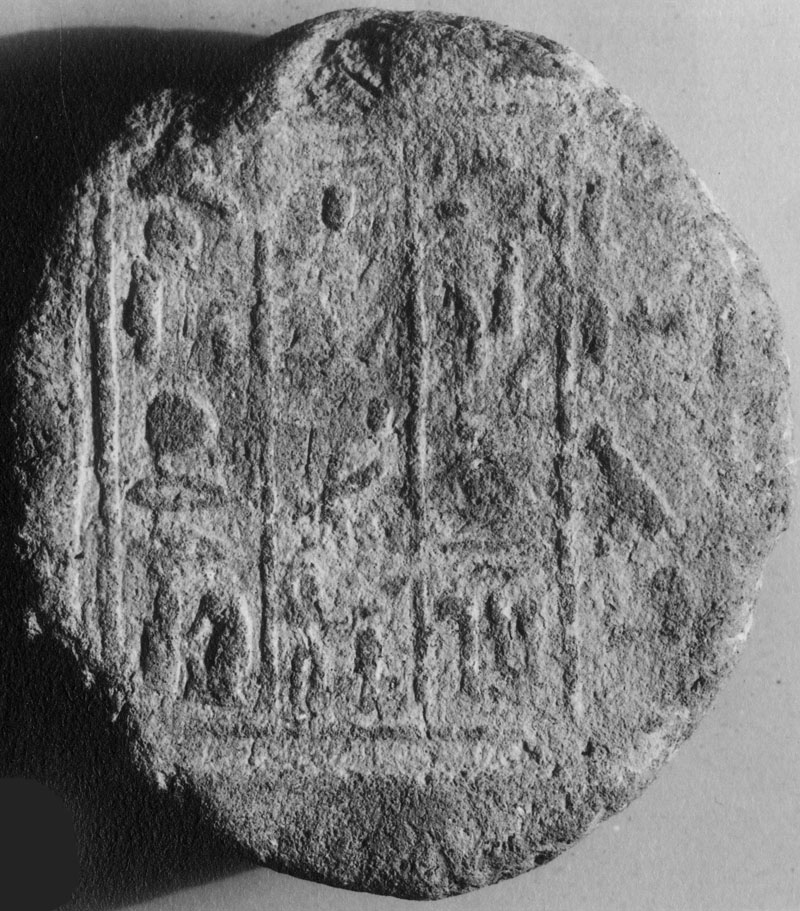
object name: cone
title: Funerary Cone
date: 1550-1295 BCE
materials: pottery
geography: egypt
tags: hieroglyphs